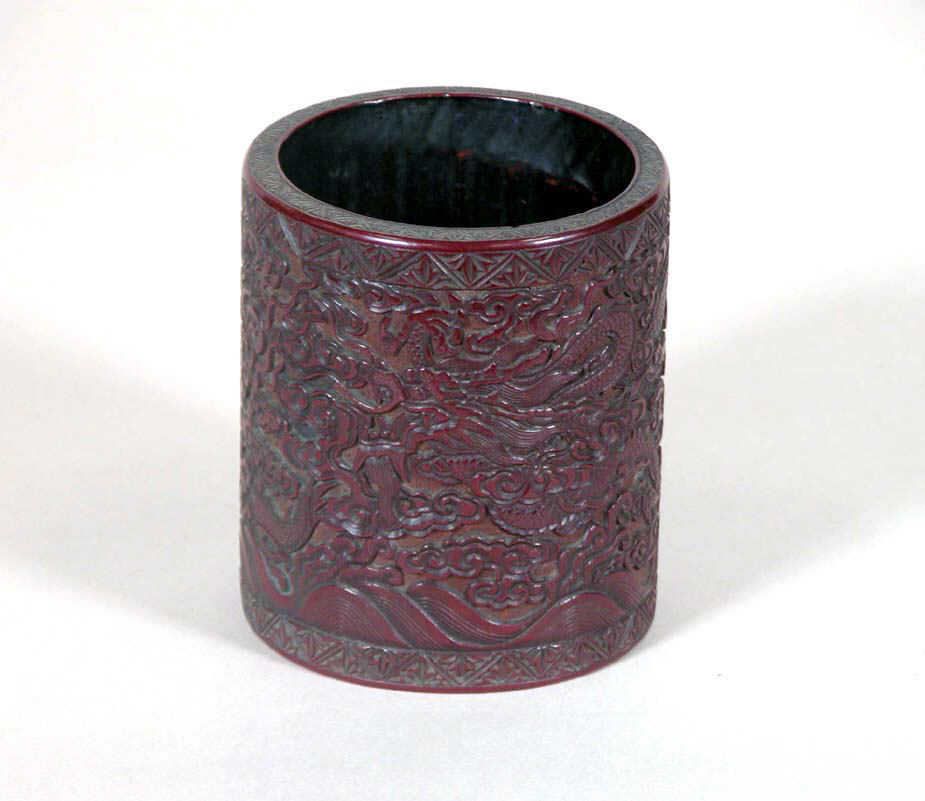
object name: brush holder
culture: chinese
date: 1736-1795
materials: lacquer, wood